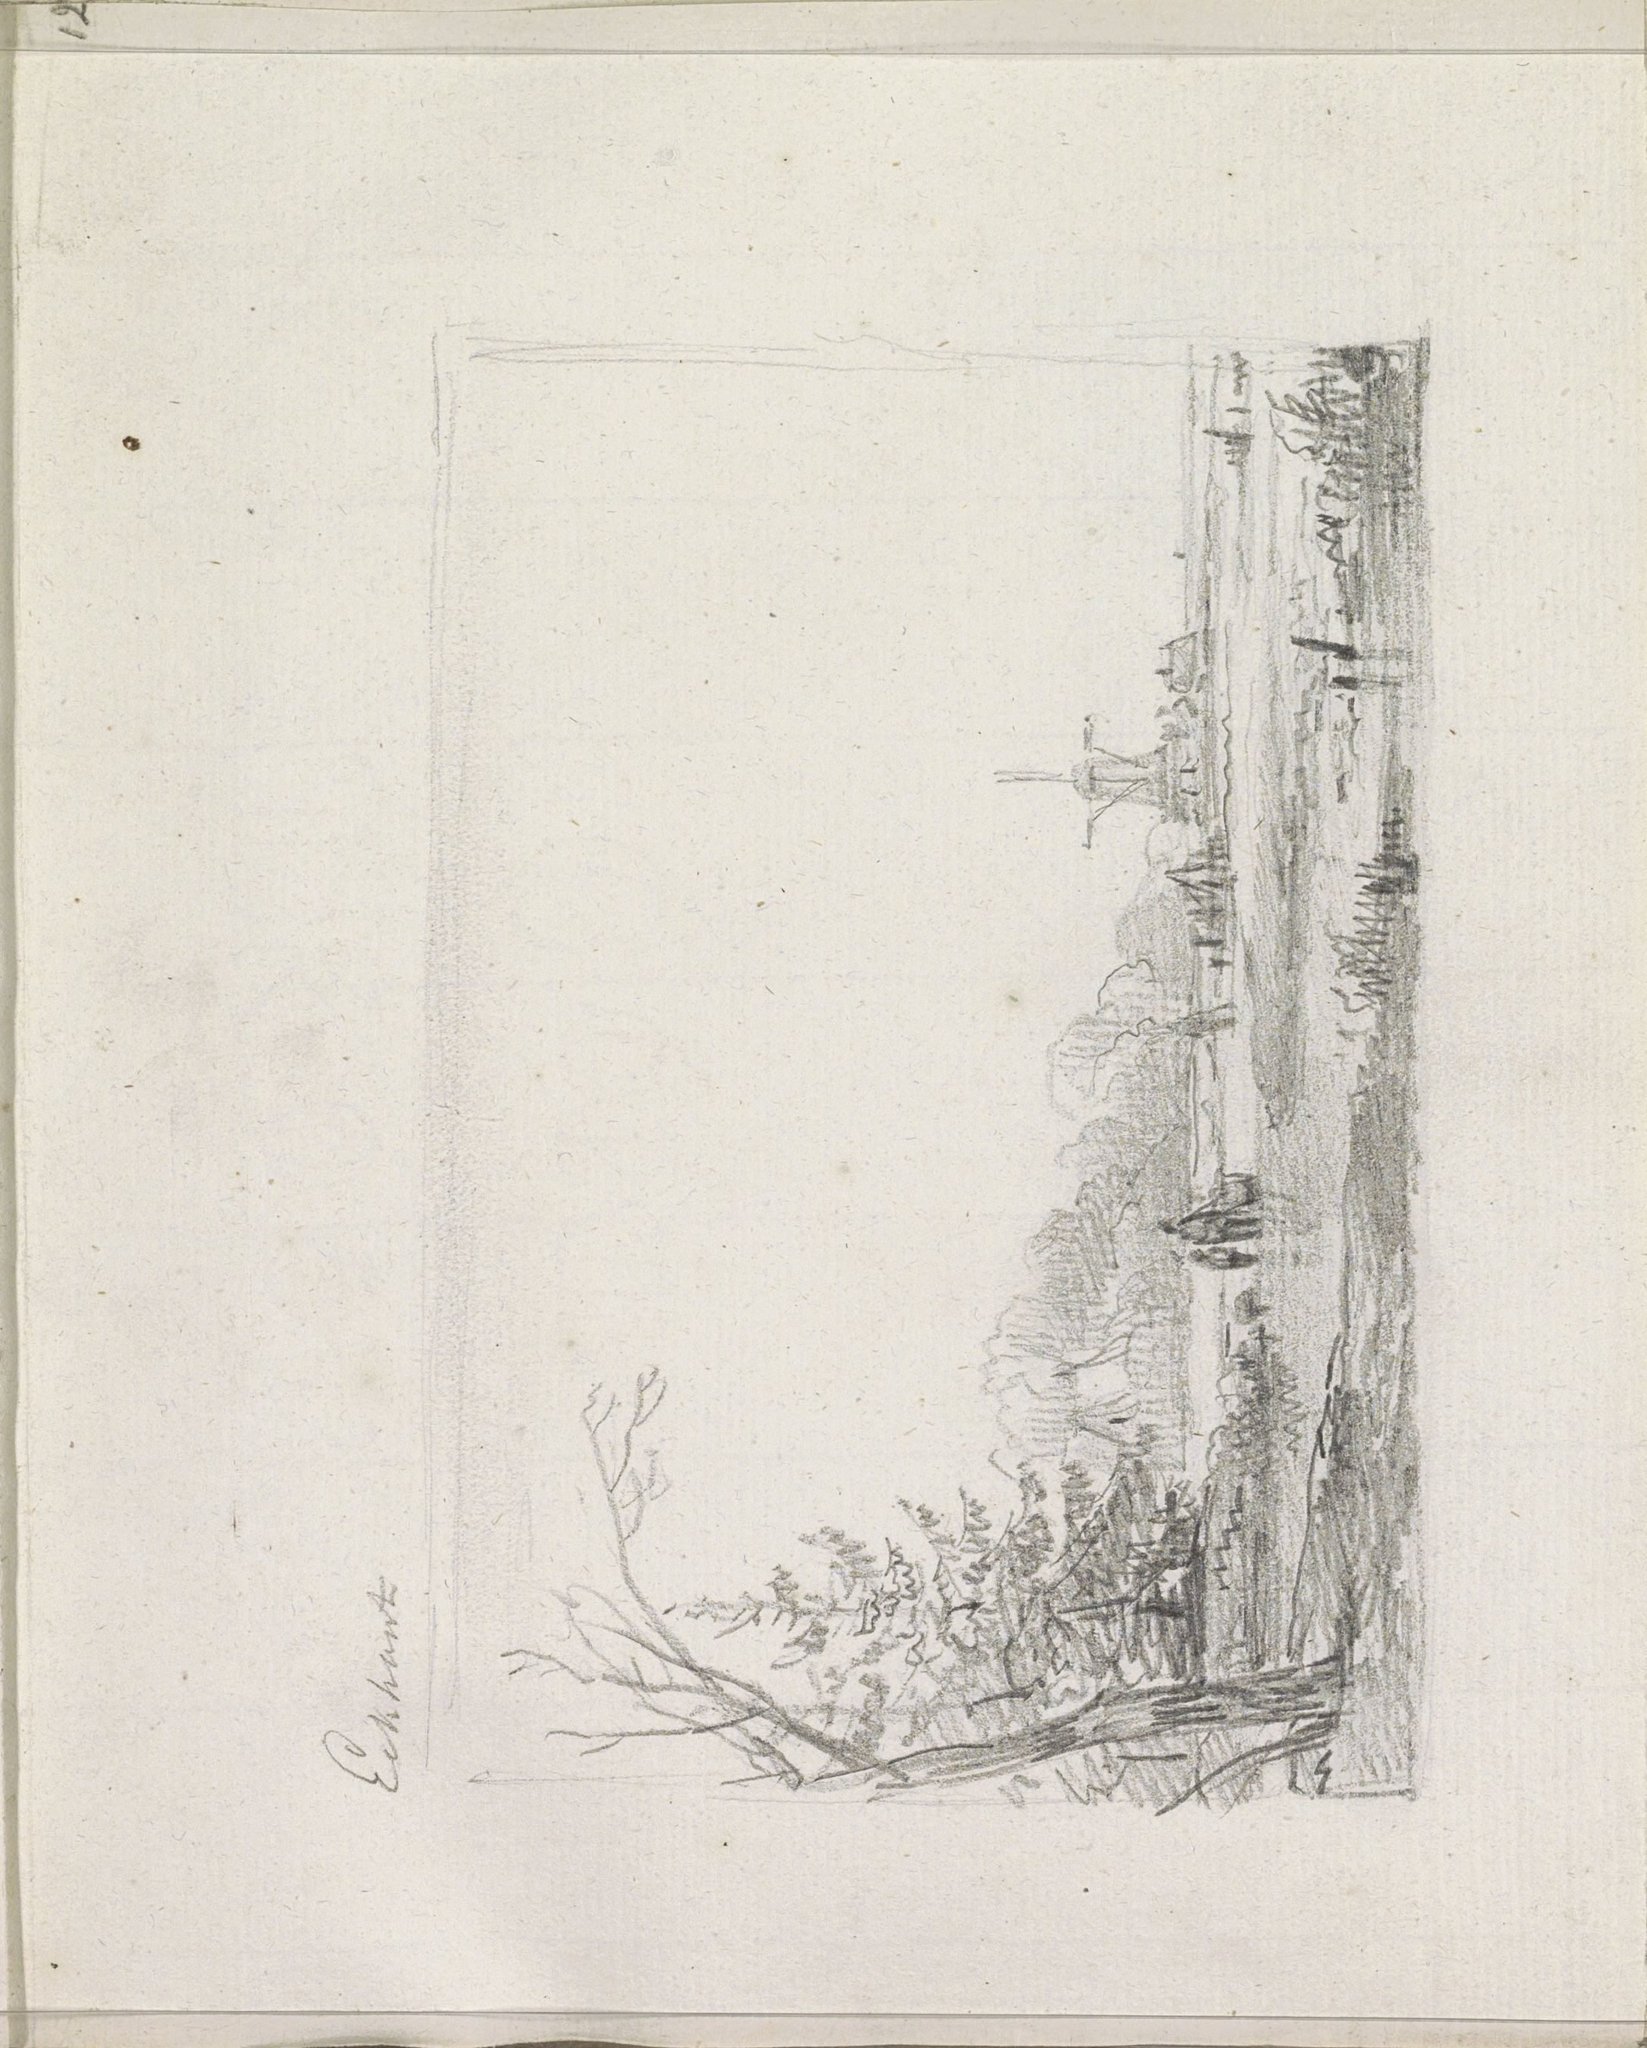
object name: sketchbook leaf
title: Polderlandschap met een molen en figuren op een bevroren vaart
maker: andreas schelfhout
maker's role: draughtsman, painter, print maker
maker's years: 1787-1870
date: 1825-1829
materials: paper, pencil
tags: frost, freezing weather, windmill in landscape, landscapes with waters, waterscapes, seascapes (in the temperate zone) (+ landscape with figures, staffage)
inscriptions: annotation: ‘Eekhout’, number: ‘12’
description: Blad 14 recto uit een schetsboek met 95 bladen.